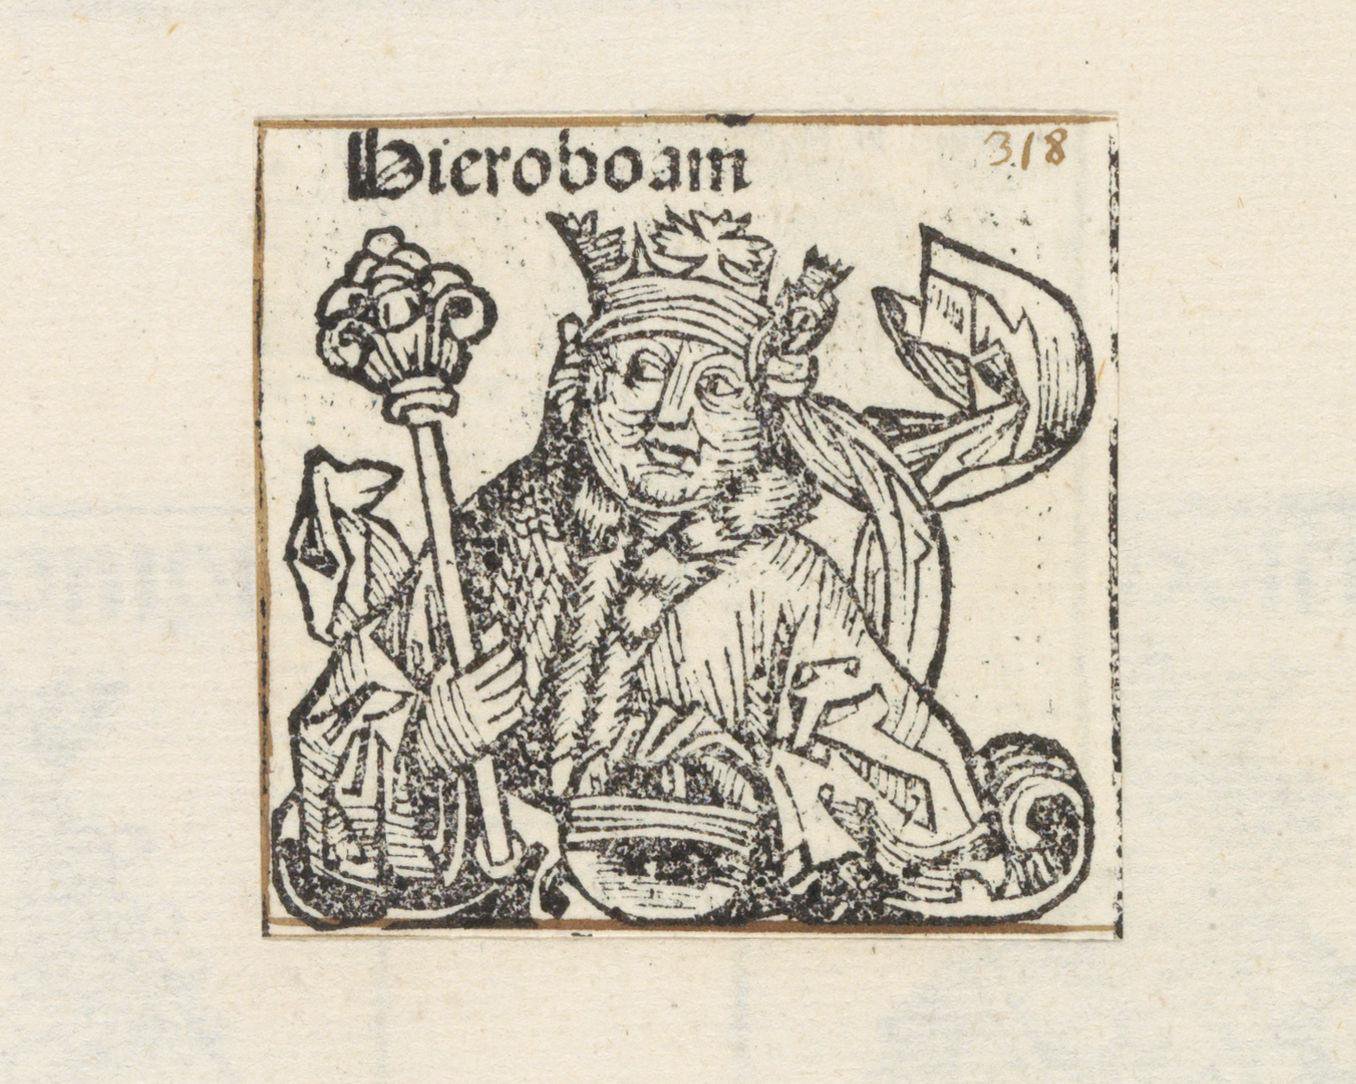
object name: album leaf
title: Jerobeam I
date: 1493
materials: paper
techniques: letterpress printing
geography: nuremberg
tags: king, persons from the old testament (not in biblical context, nor occurring in legendary/historical extensions included in division 71)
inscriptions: inscription: ‘318’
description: Een bloemkelk met een koning, naar links gekeerd. Hij heeft een rijksappel en een scepter in zijn handen. De voorstelling is onderdeel van de opeenvolging van de koningen van Israël in de Liber Chronicarum. De tekst identificeert de man als Jerobeam I. De prent maakt deel uit van een album.